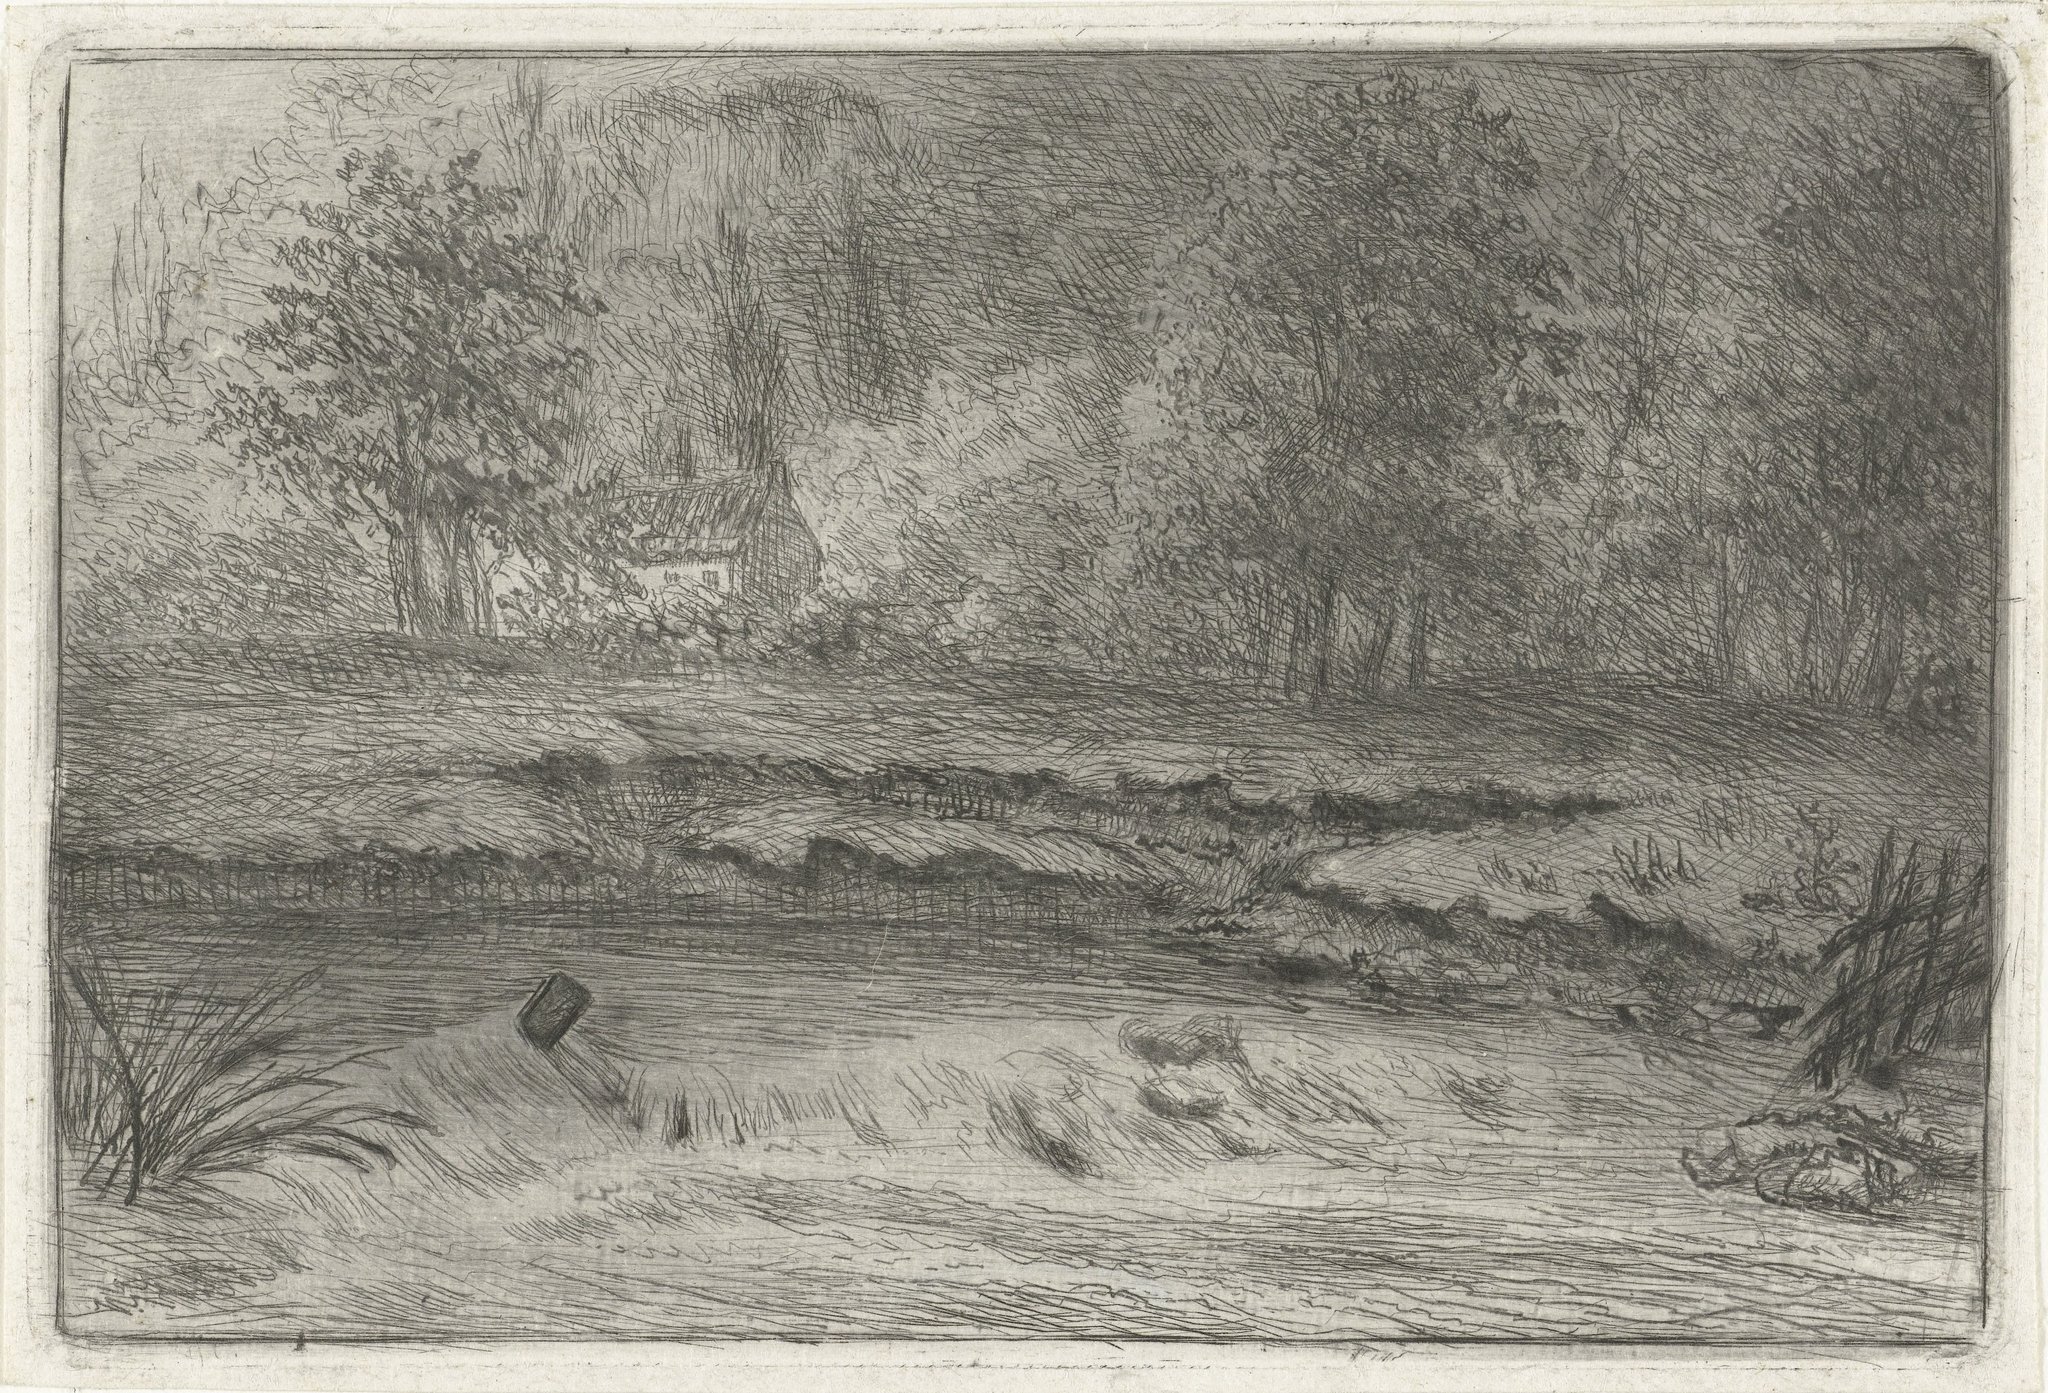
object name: print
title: Rivier met waterval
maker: louis bernard coclers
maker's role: draughtsman, print maker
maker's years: 1741-1817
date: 1756-1817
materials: paper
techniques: drypoint, etching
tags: waterfall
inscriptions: collector's mark: Lugt 2228